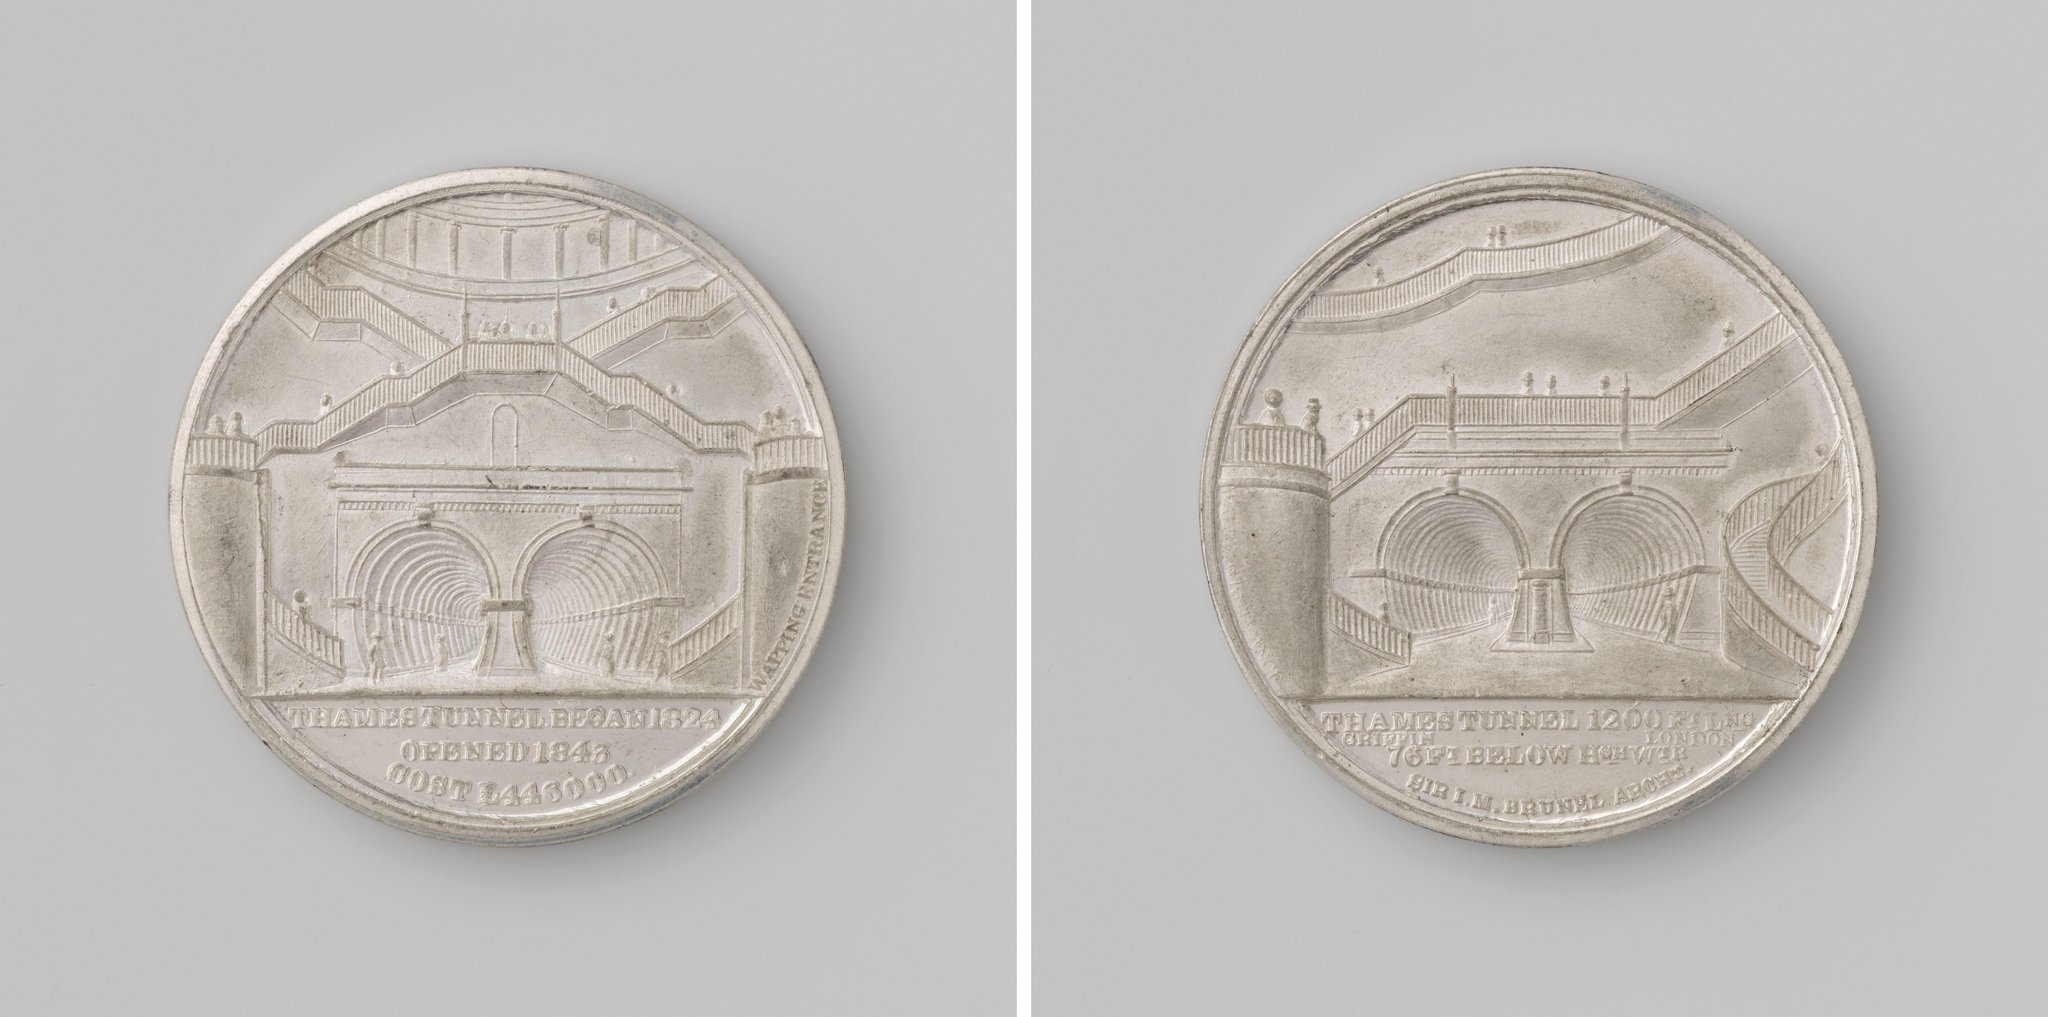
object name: history medal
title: Opening van de Thamestunnel te Londen 1843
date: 1843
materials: tin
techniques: striking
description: Tinnen penning, op de voorzijde het trappenhuis naar de Thamestunnel, met afsnedetekst, op de keerzijde het trappenhuis aan de andere zijde, met afsnedetekst.